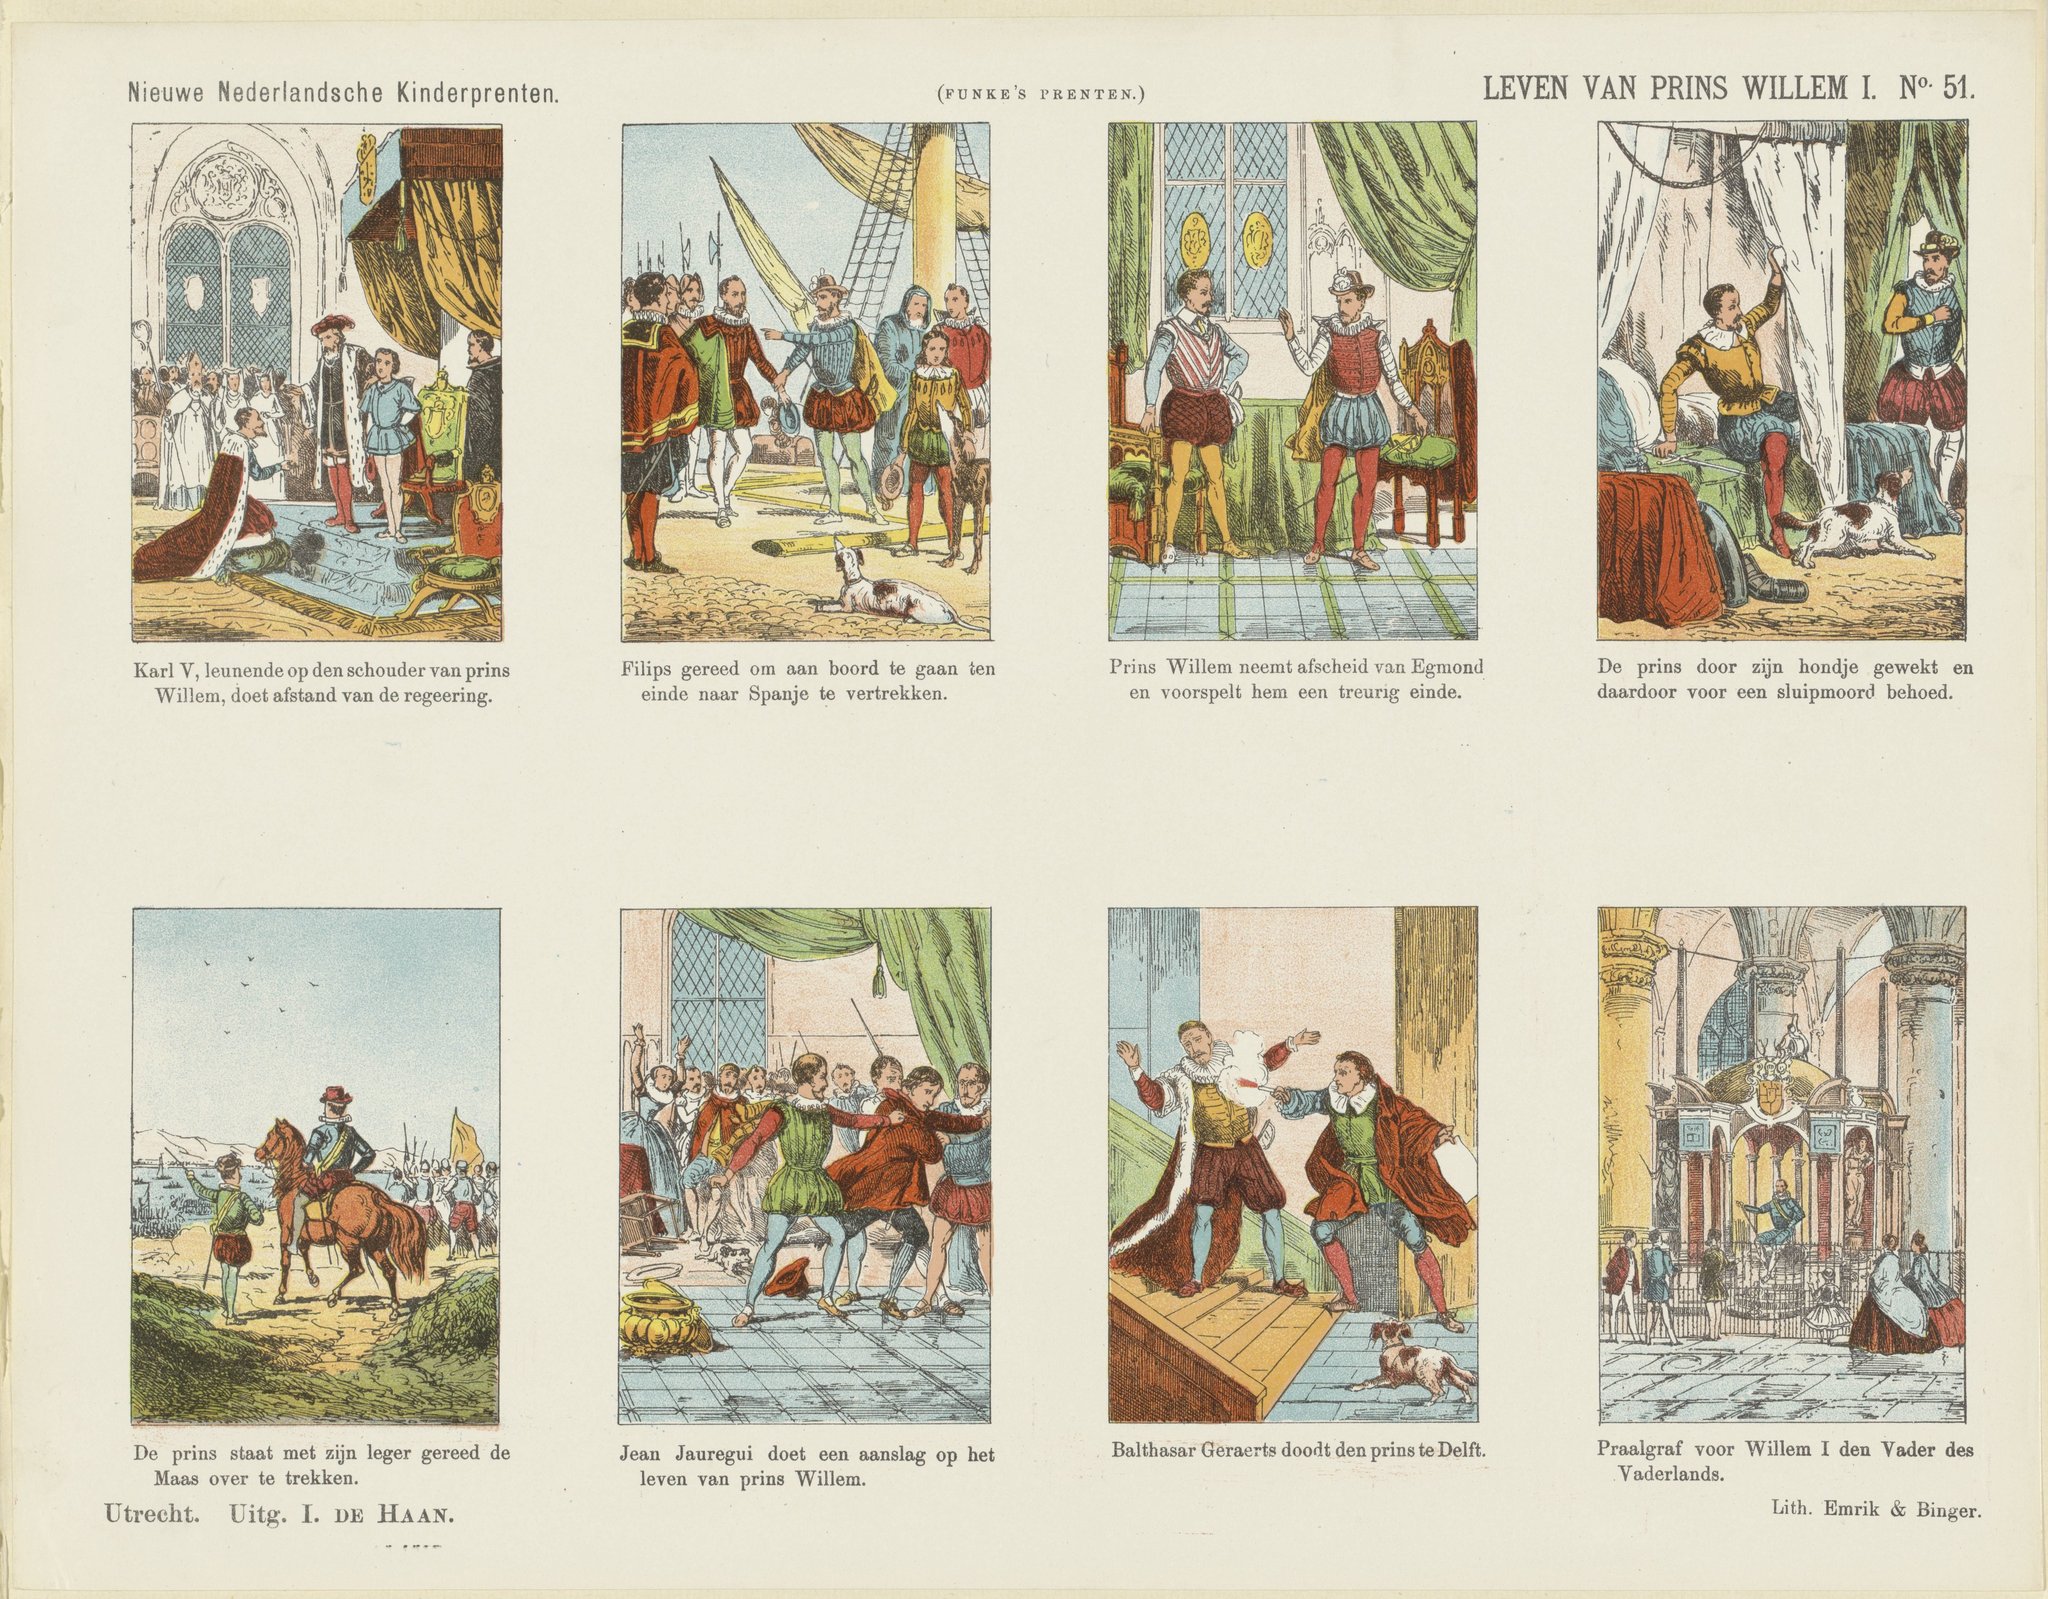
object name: print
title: Funke´s prenten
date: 1875-1903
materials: paper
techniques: lithograph, letterpress printing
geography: haarlem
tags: philip ii of spain, delft, william i (prince of orange), ghent, charles v (holy roman emperor and king of spain)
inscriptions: collector's mark: Lugt 2760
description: Blad met 8 voorstellingen over het leven van Willem I. Onder elke afbeelding een tweeregelig vers. Genummerd rechtsboven: No. 51.